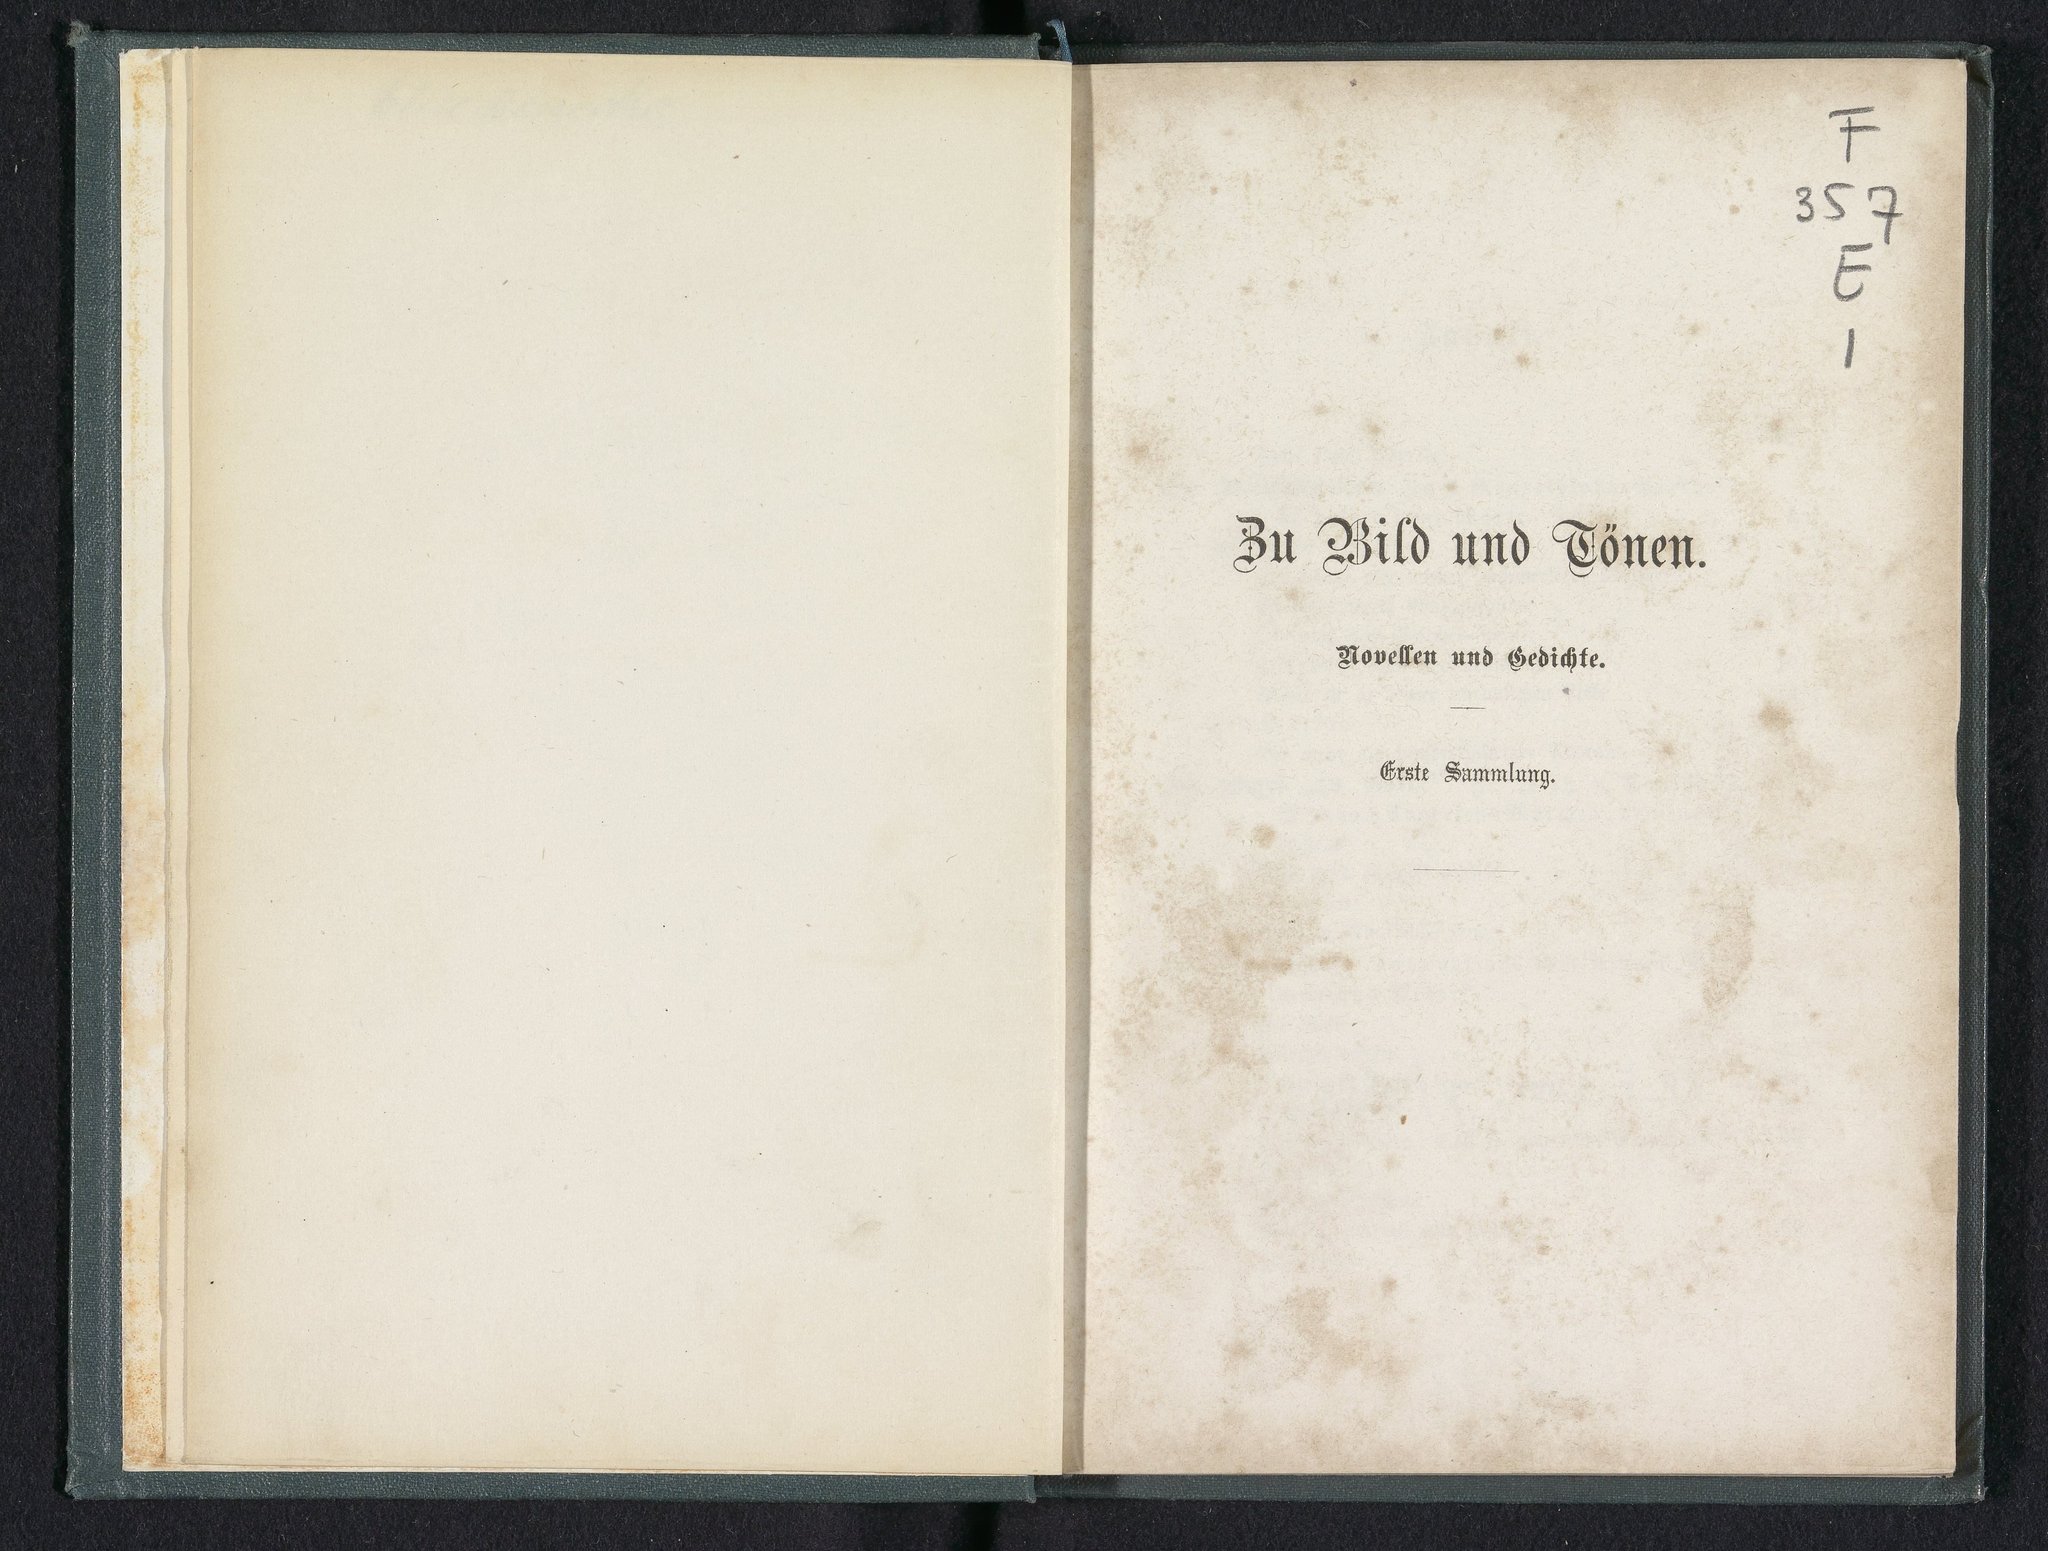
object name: book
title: Zu Bild und Tönen : Novellen und Gedichte zu Wilh. v. Kaulbach, F. Mendelssohn-B[artholdy] : erste Sammlung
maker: otto schröder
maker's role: publisher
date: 1862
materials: cardboard, linen, paper, photographic support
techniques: albumen print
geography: berlin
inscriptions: name: ‘Elise Benechre.’